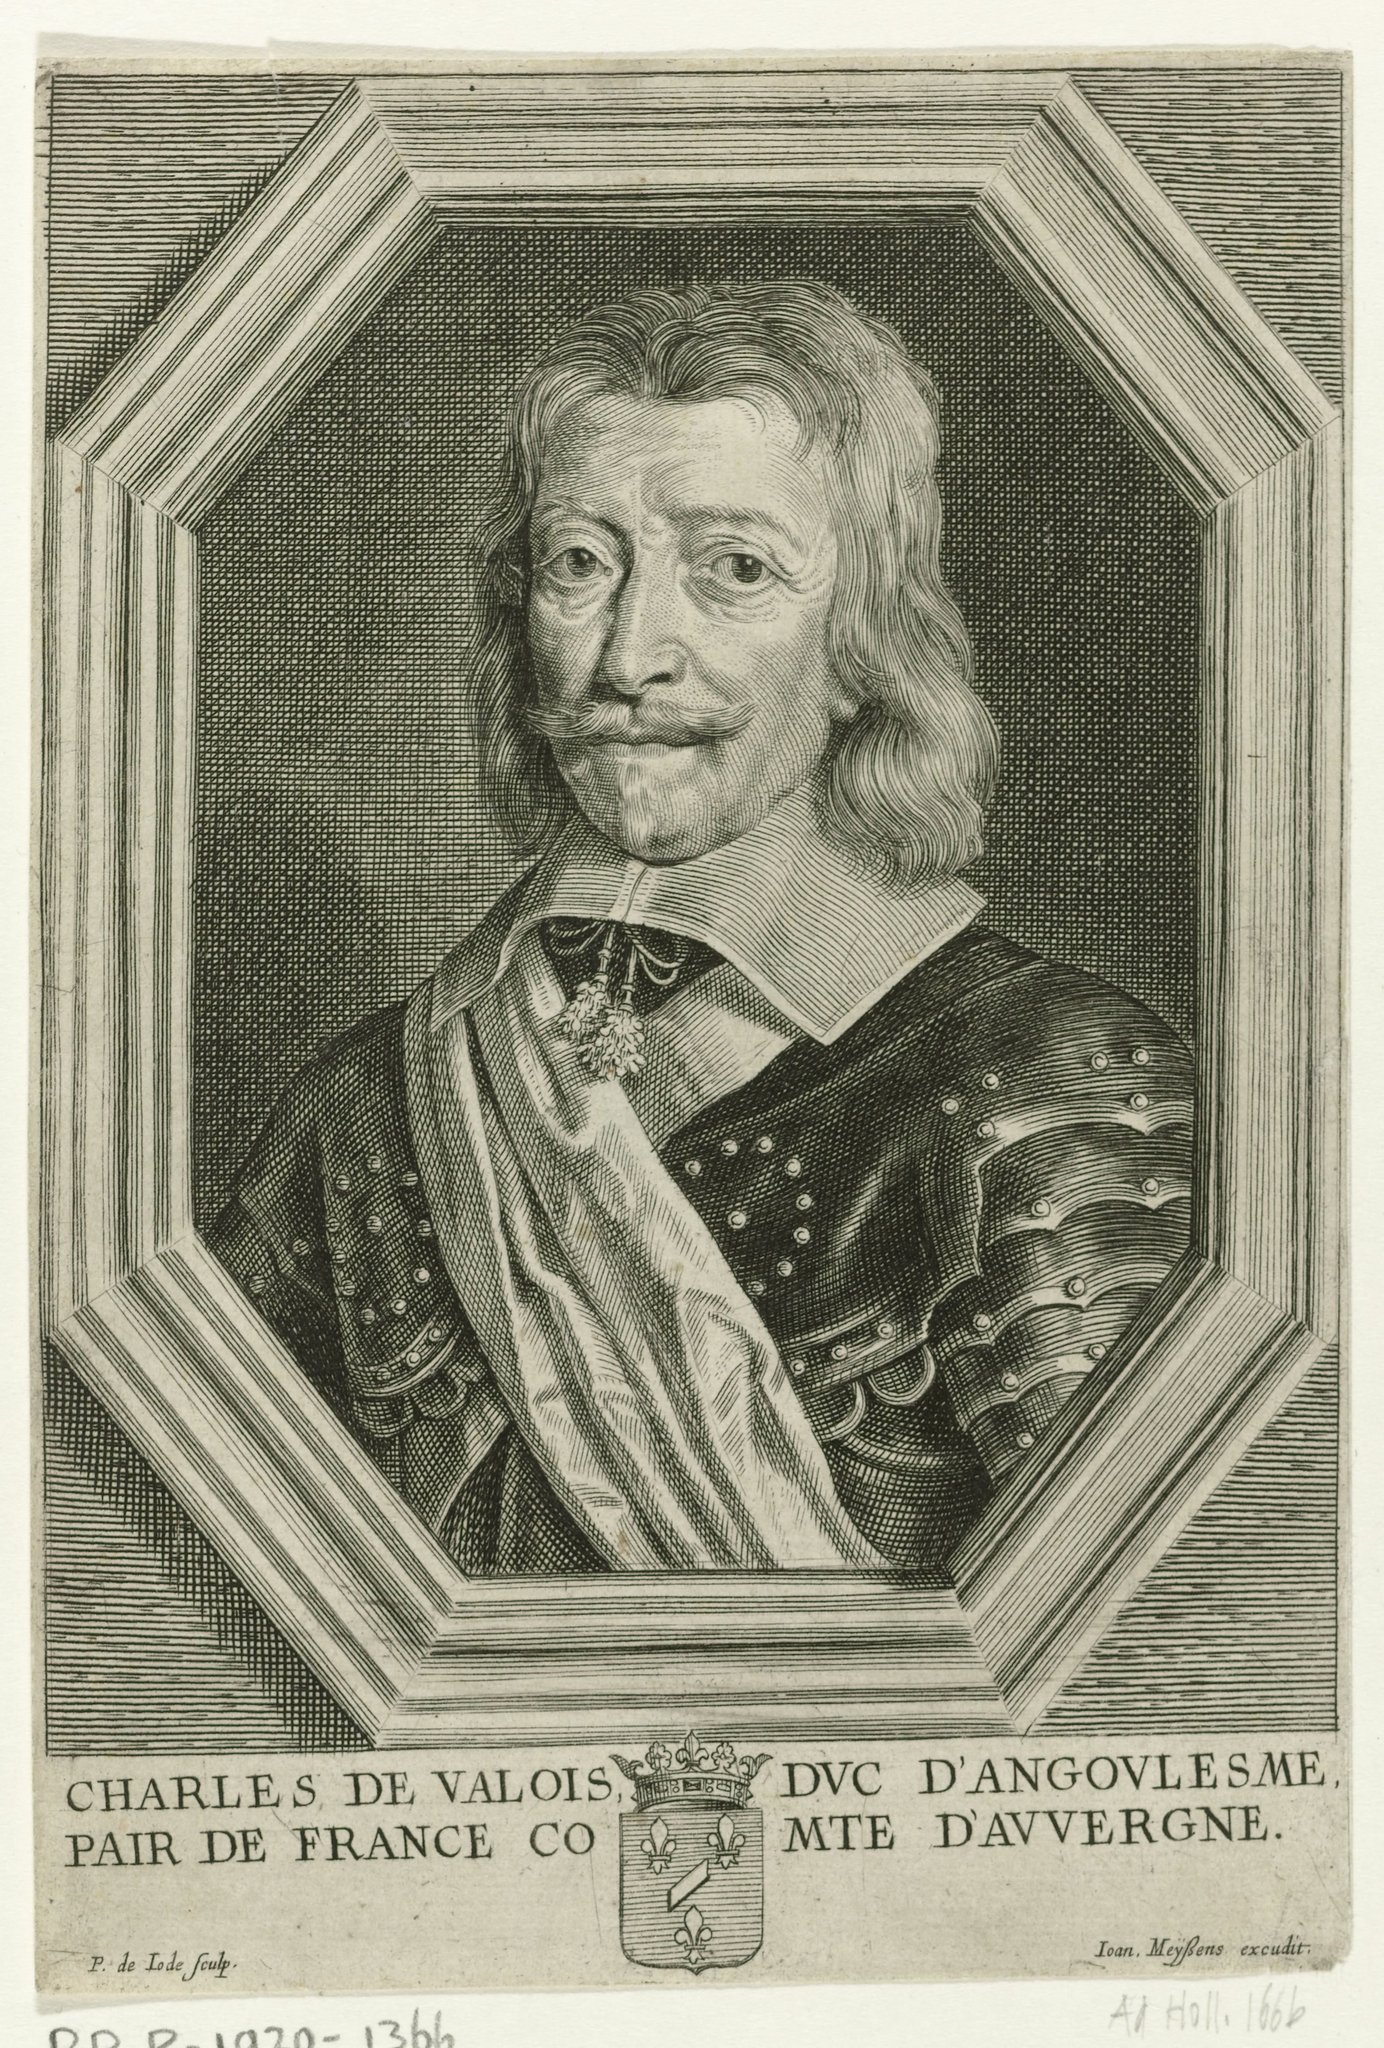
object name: print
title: Theatrum pontificum, imperatorum, regum, ducum, principum, etc.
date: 1628-1670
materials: paper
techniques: engraving, etching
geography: antwerp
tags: karel van valois (hertog van angoulême), armour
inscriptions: collector's mark: Lugt 2228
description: Busteportret van Karel van Valois, in harnas. Het portret is gevat in een achthoekige omlijsting. In de marge het wapenschild van de geportretteerde en een tweeregelig onderschrift in het Frans.